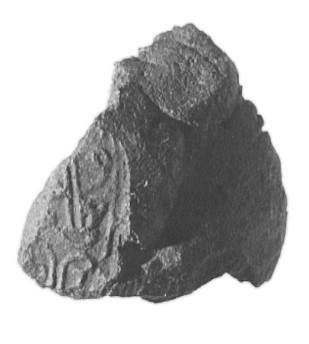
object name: sealing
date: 2030-1640 BCE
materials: clay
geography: egypt